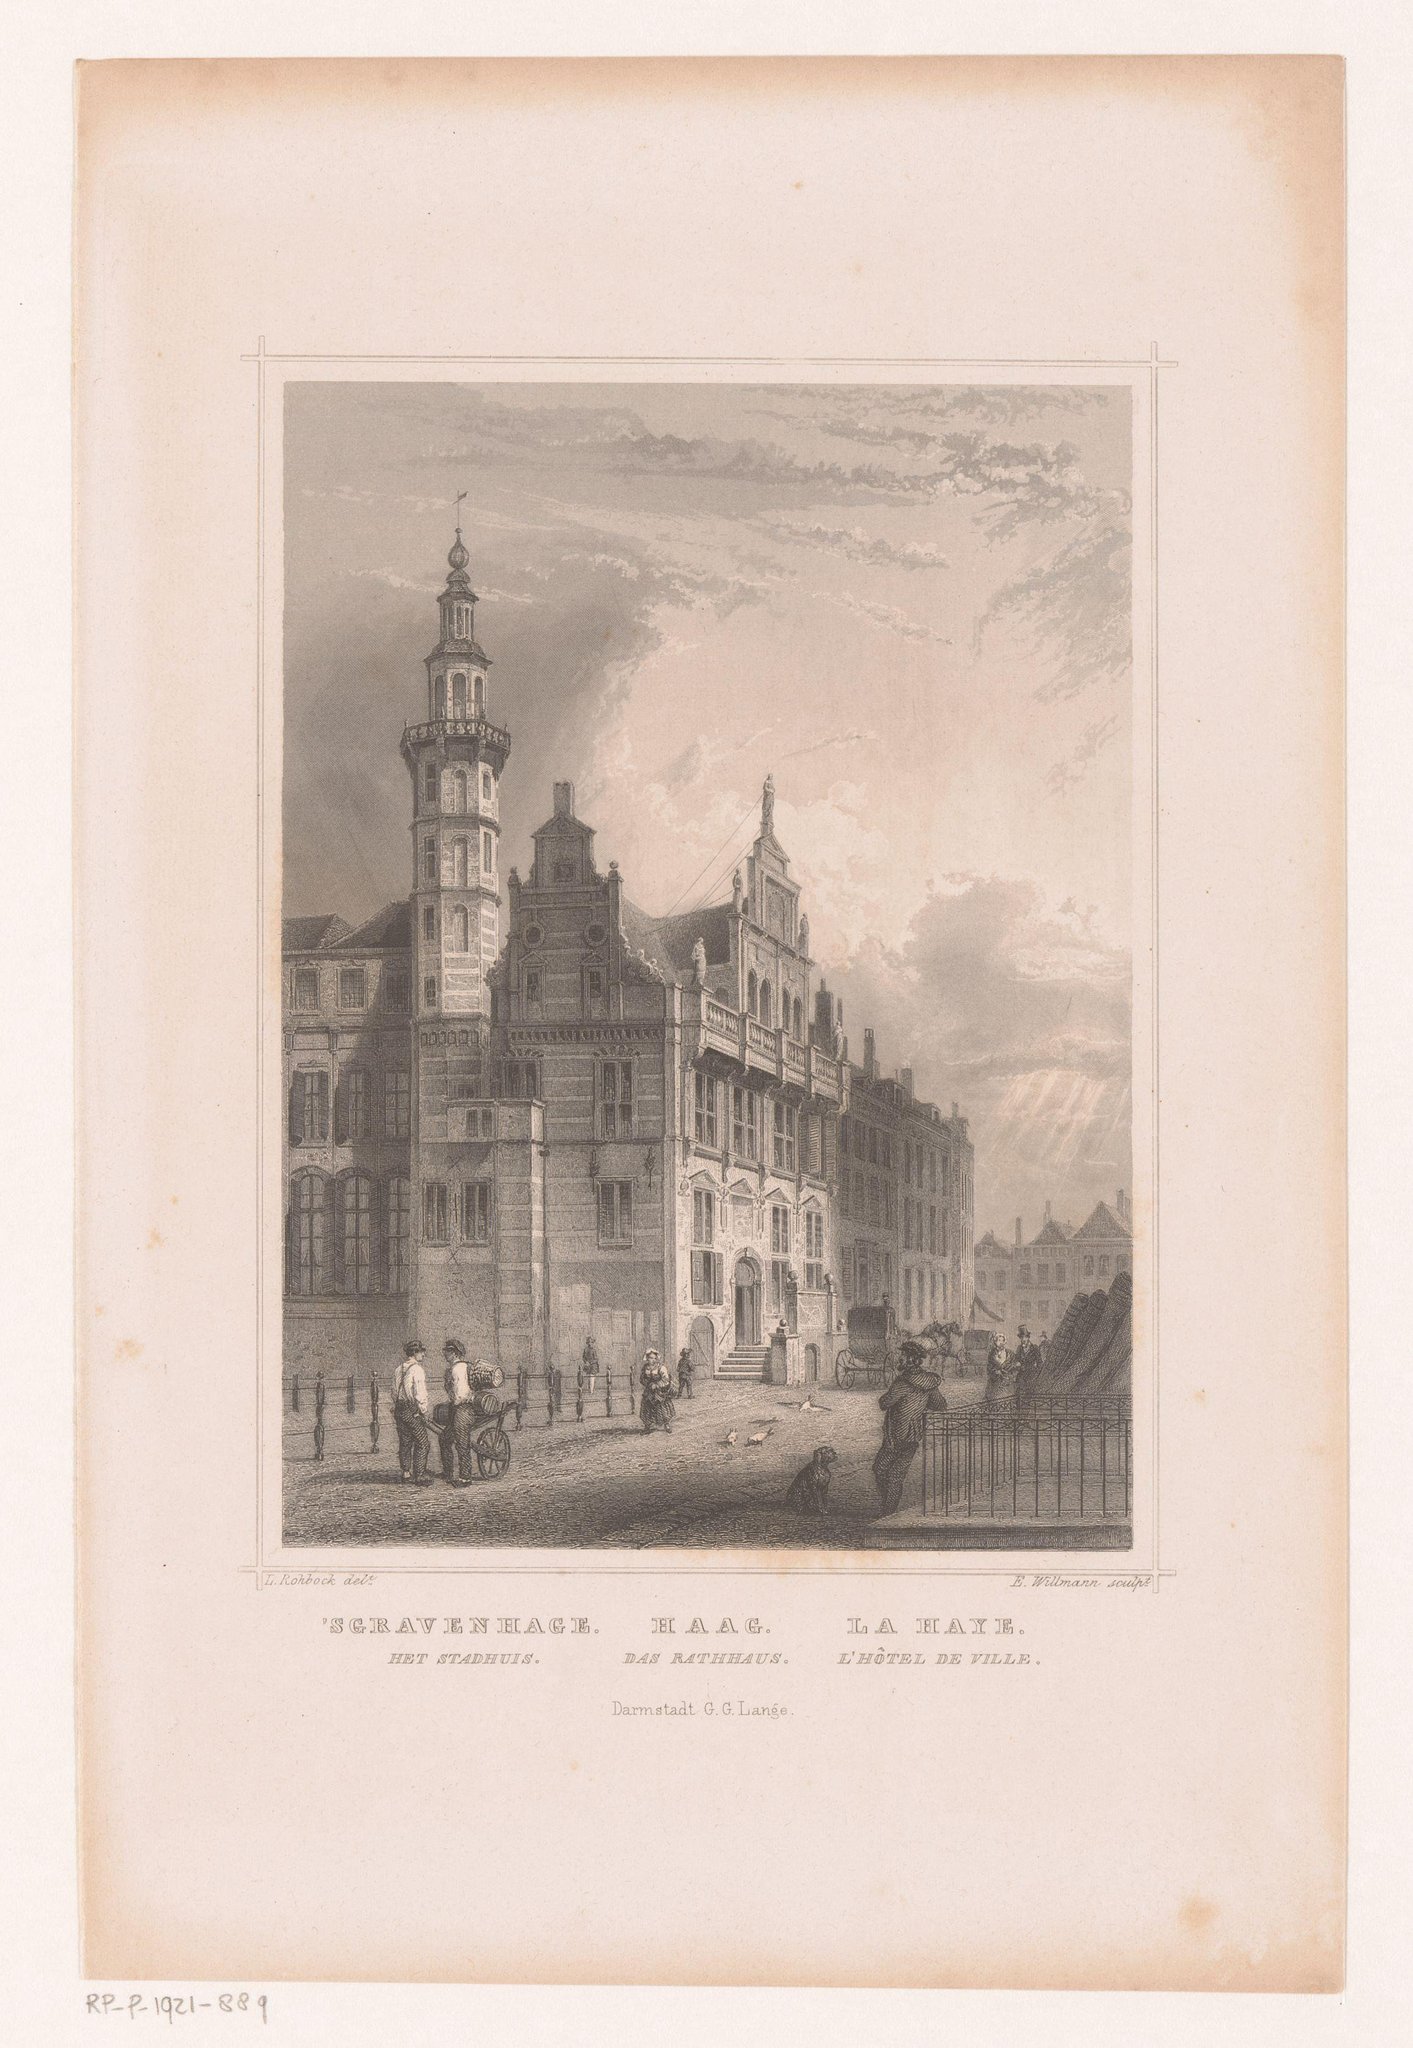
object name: print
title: Gezicht op het stadhuis van Den Haag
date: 1834-1843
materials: paper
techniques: engraving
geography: germany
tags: city-view in general; 'veduta', townhall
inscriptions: collector's mark: Lugt 2233